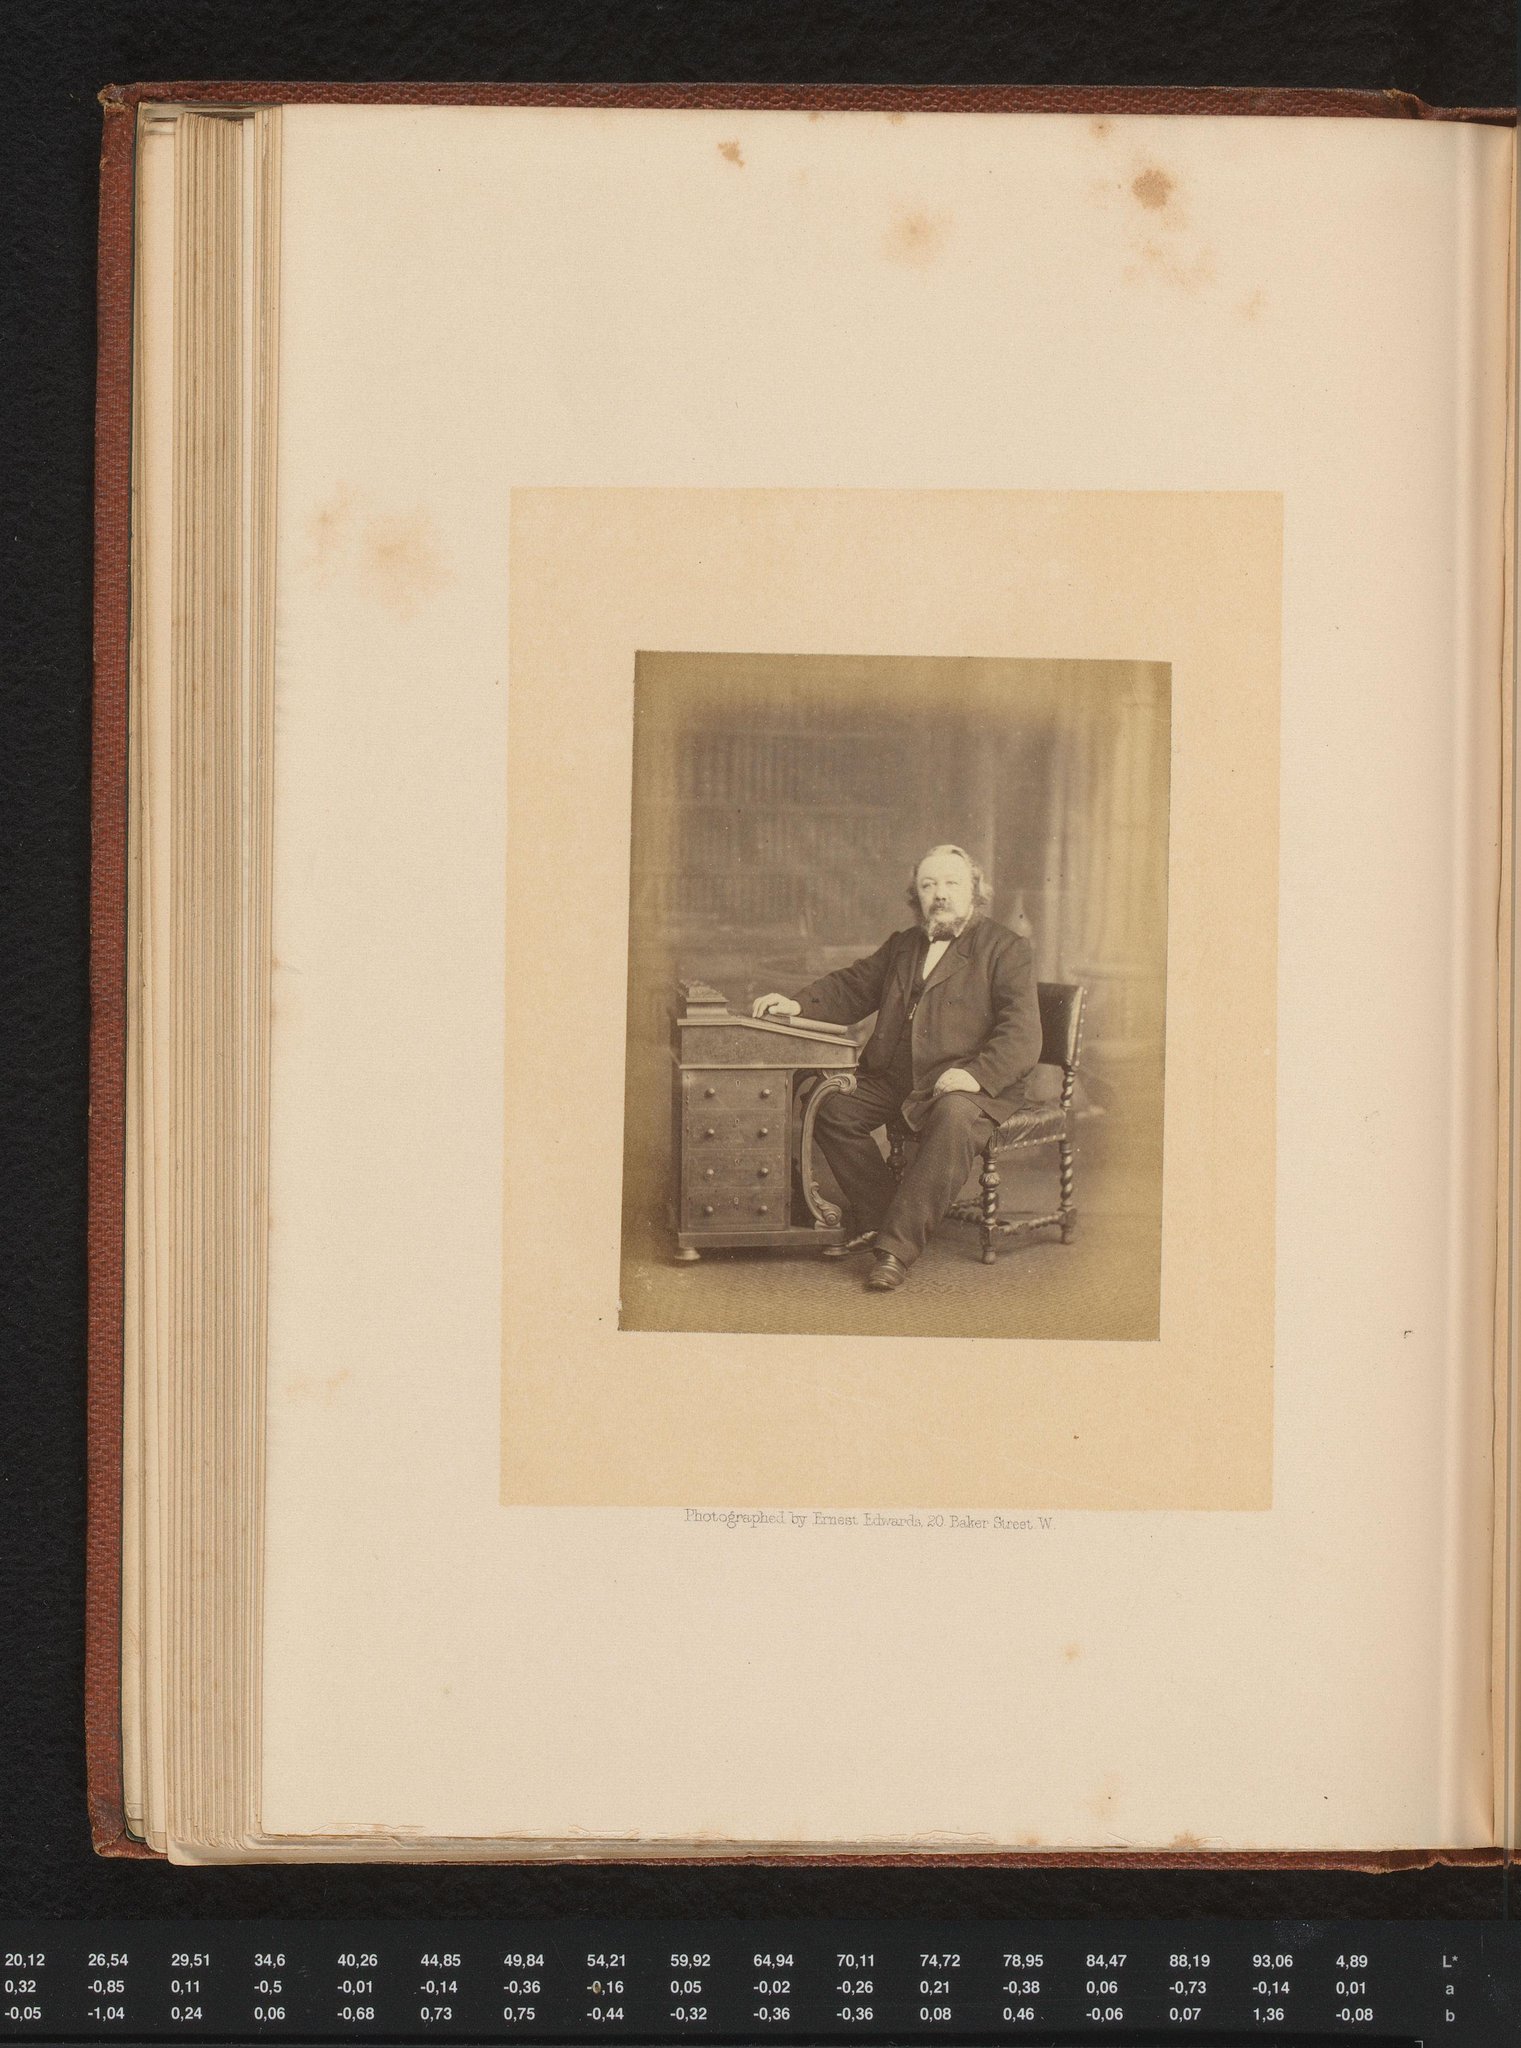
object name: page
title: Portret van de dichter Ferdinand Freiligrath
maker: ernest edwards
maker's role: fotograaf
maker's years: 1837-1903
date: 1861-1866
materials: paper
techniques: albumen print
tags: ferdinand freiligrath, portrait of a writer